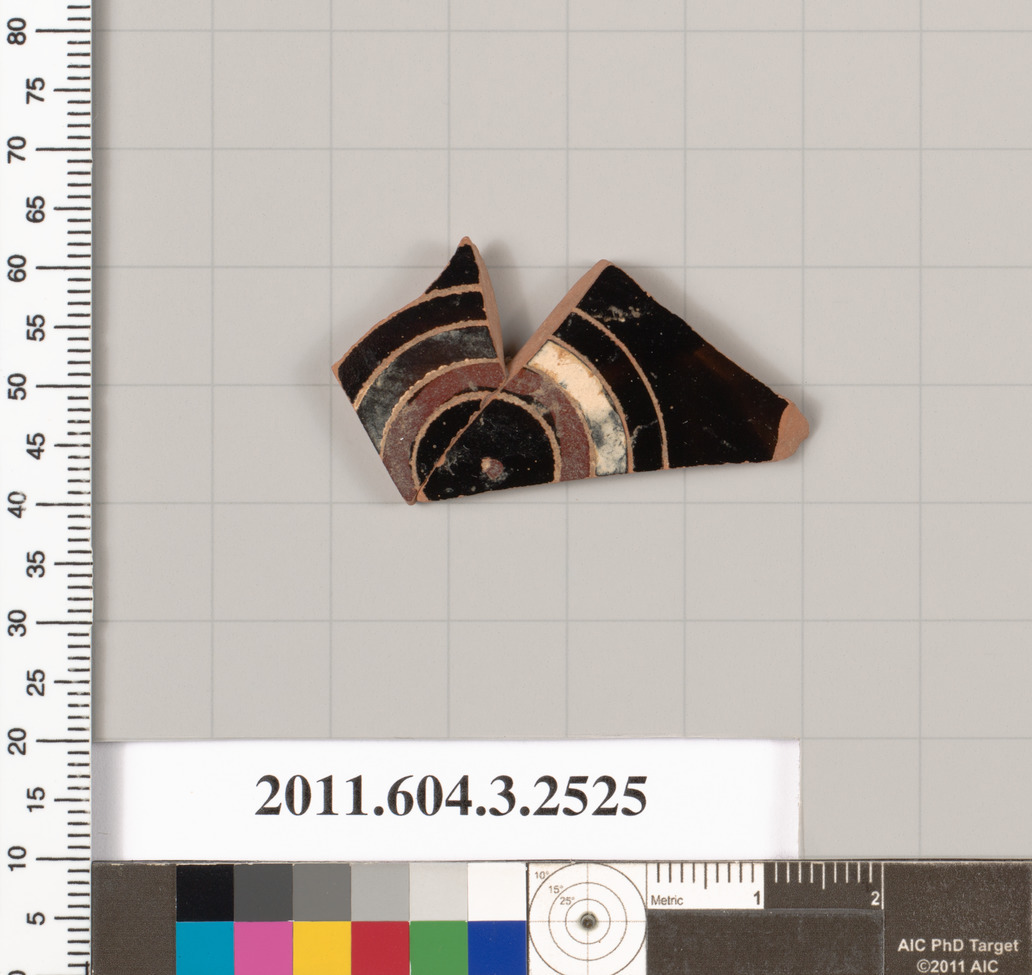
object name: kylix fragment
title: Terracotta fragment of a kylix: eye-cup (drinking cup)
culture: greek, attic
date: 530-510 BCE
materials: terracotta